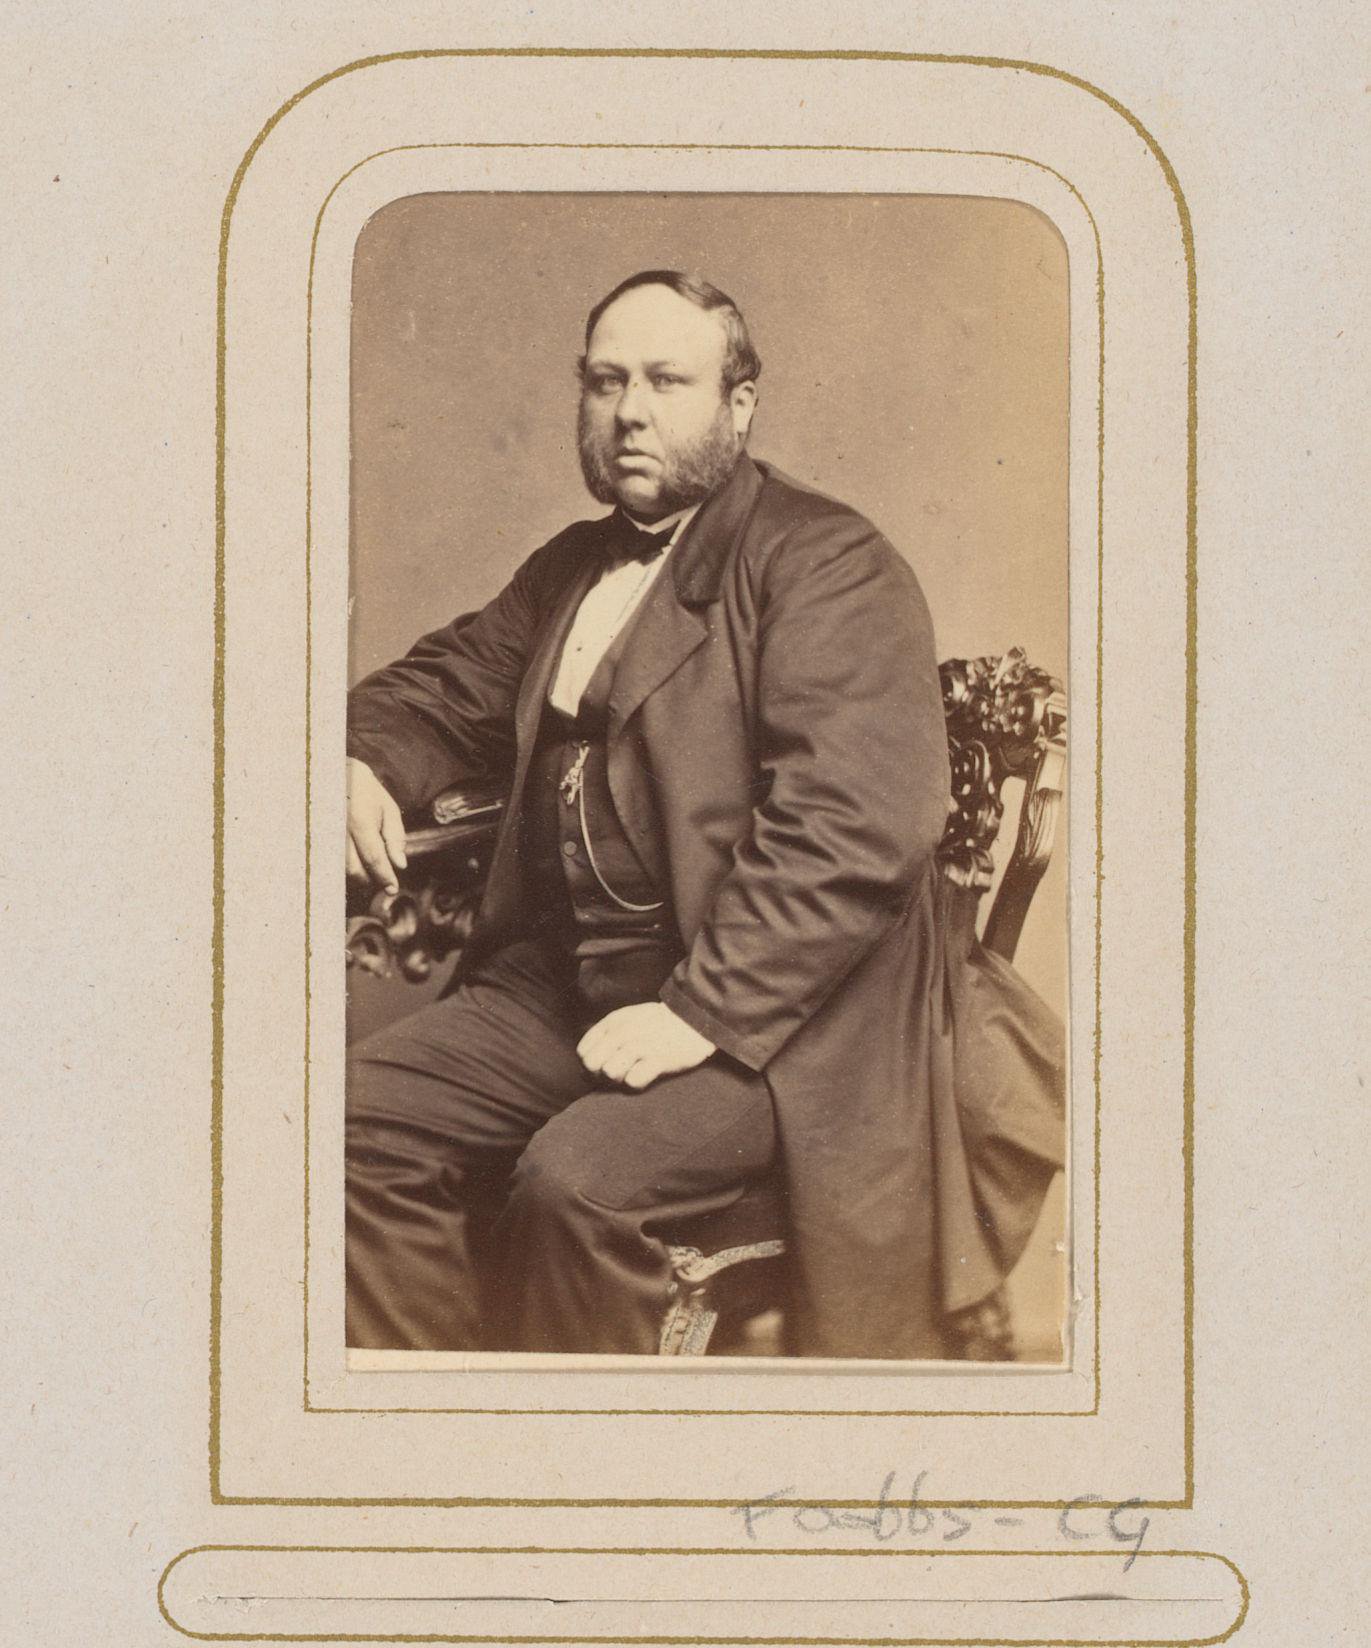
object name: album leaf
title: Portret van Salomon Frederik Sieuwerts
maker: matthijs adolph conen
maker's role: painter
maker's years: 1833-1894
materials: cardboard, photographic support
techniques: albumen print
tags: historical persons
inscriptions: inscription: ‘Adolphe Conen/ Peintre-Photographe/ Amsterdam/ Plantage Middenlaan 132’, annotation: ‘Salomo Frederik Sieuwerts’